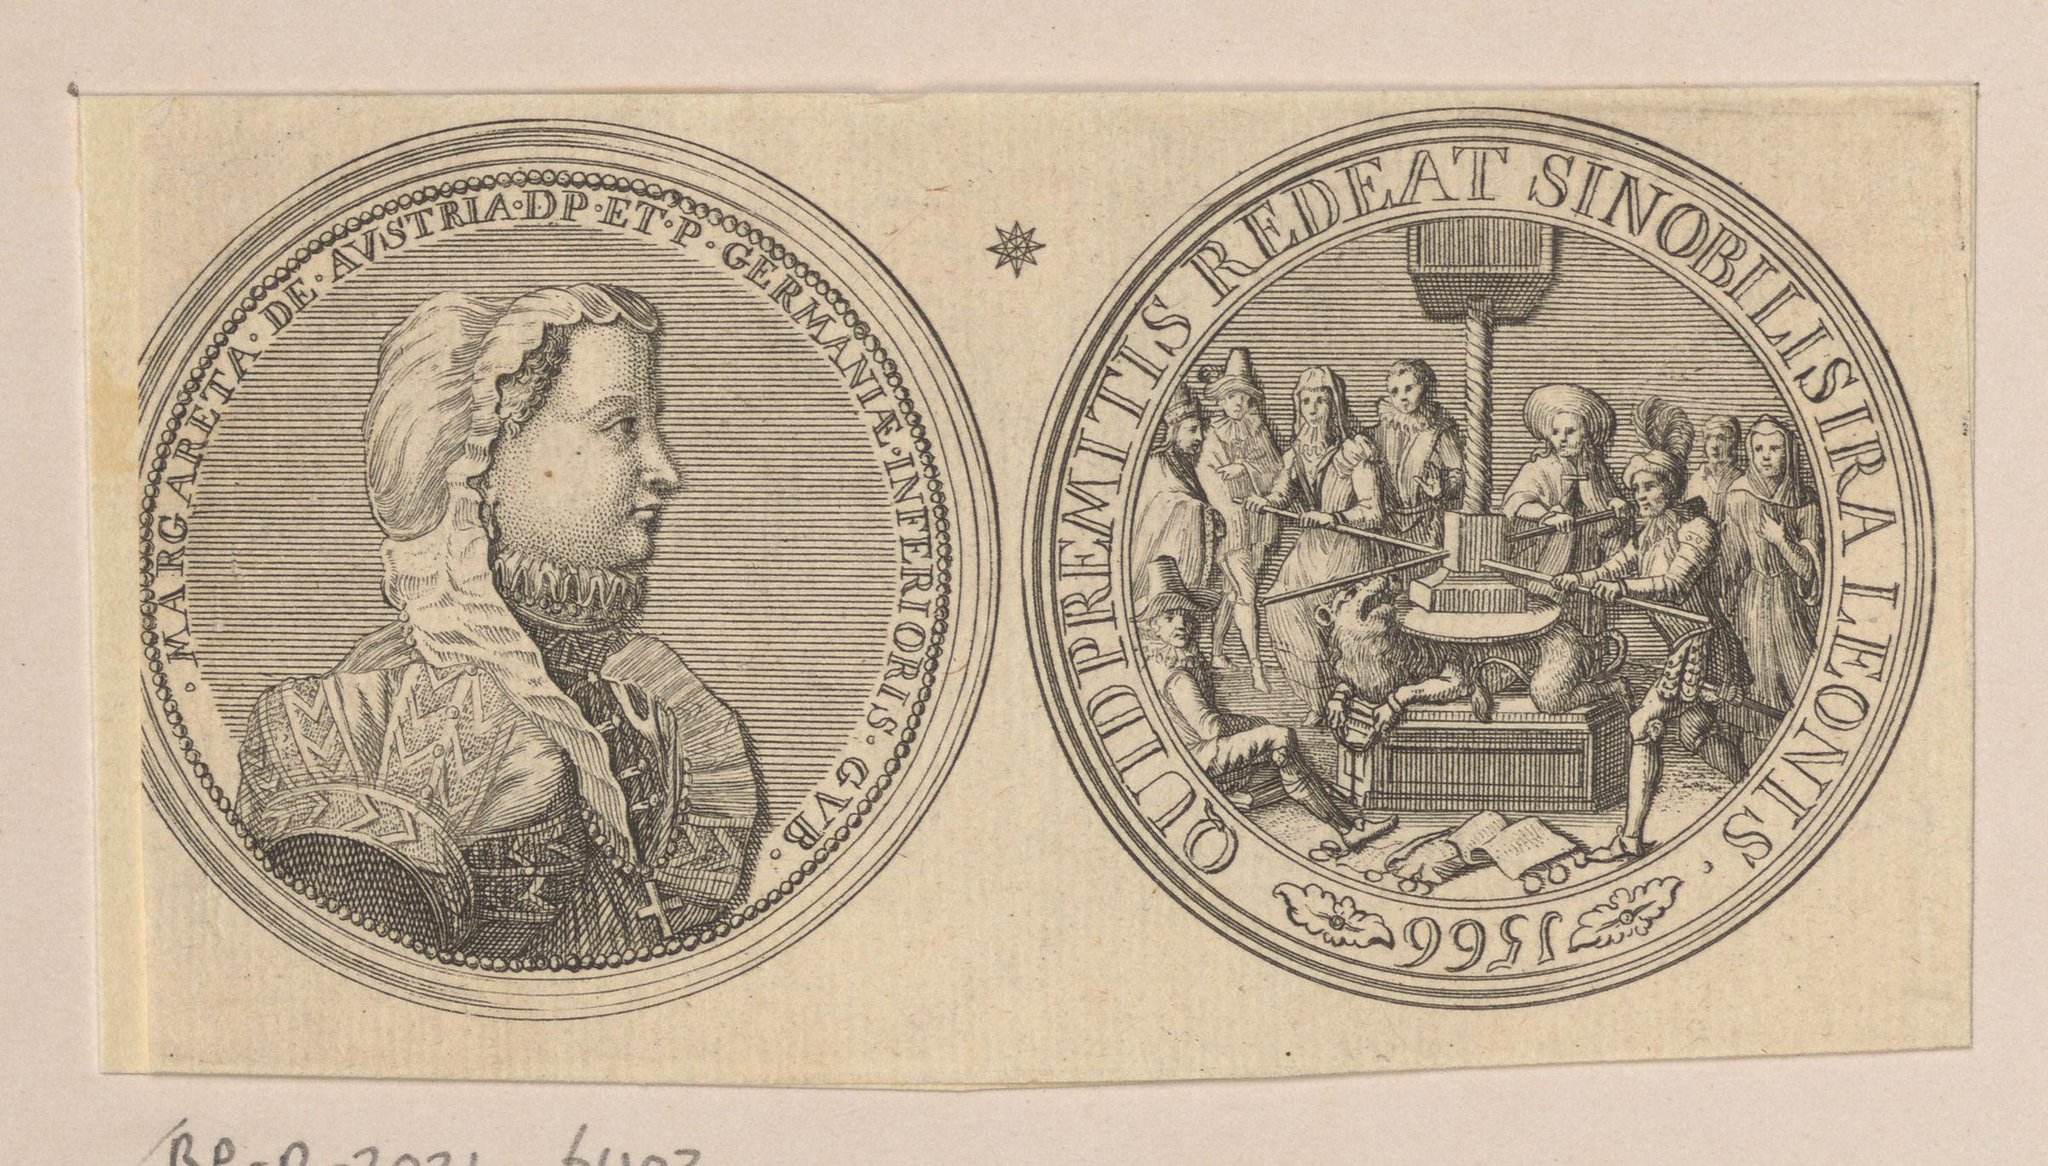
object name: print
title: Voor- en achterzijde van een penning met het portret van Margaretha van Parma en de Nederlandse leeuw tussen de inquisitiepers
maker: Anonymous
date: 1723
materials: paper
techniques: engraving, etching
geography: northern netherlands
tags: antoine perrenot de granvelle, tools, aids, implements ~ crafts and industries: press, personifications of countries, nations, states, districts, etc., historical persons - bb - woman, medal (considered as a piece of sculpture, regardless of its specific function), inquisition, regent, substitute ruler; viceroy - bb - female ruler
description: Met randschrift in het Latijn. Op de achterzijde van de penning wordt de Nederlandse leeuw verplet tussen een pers door Margaretha van Parma, de kardinaal van Granvelle en een Spaanse krijgsknecht.